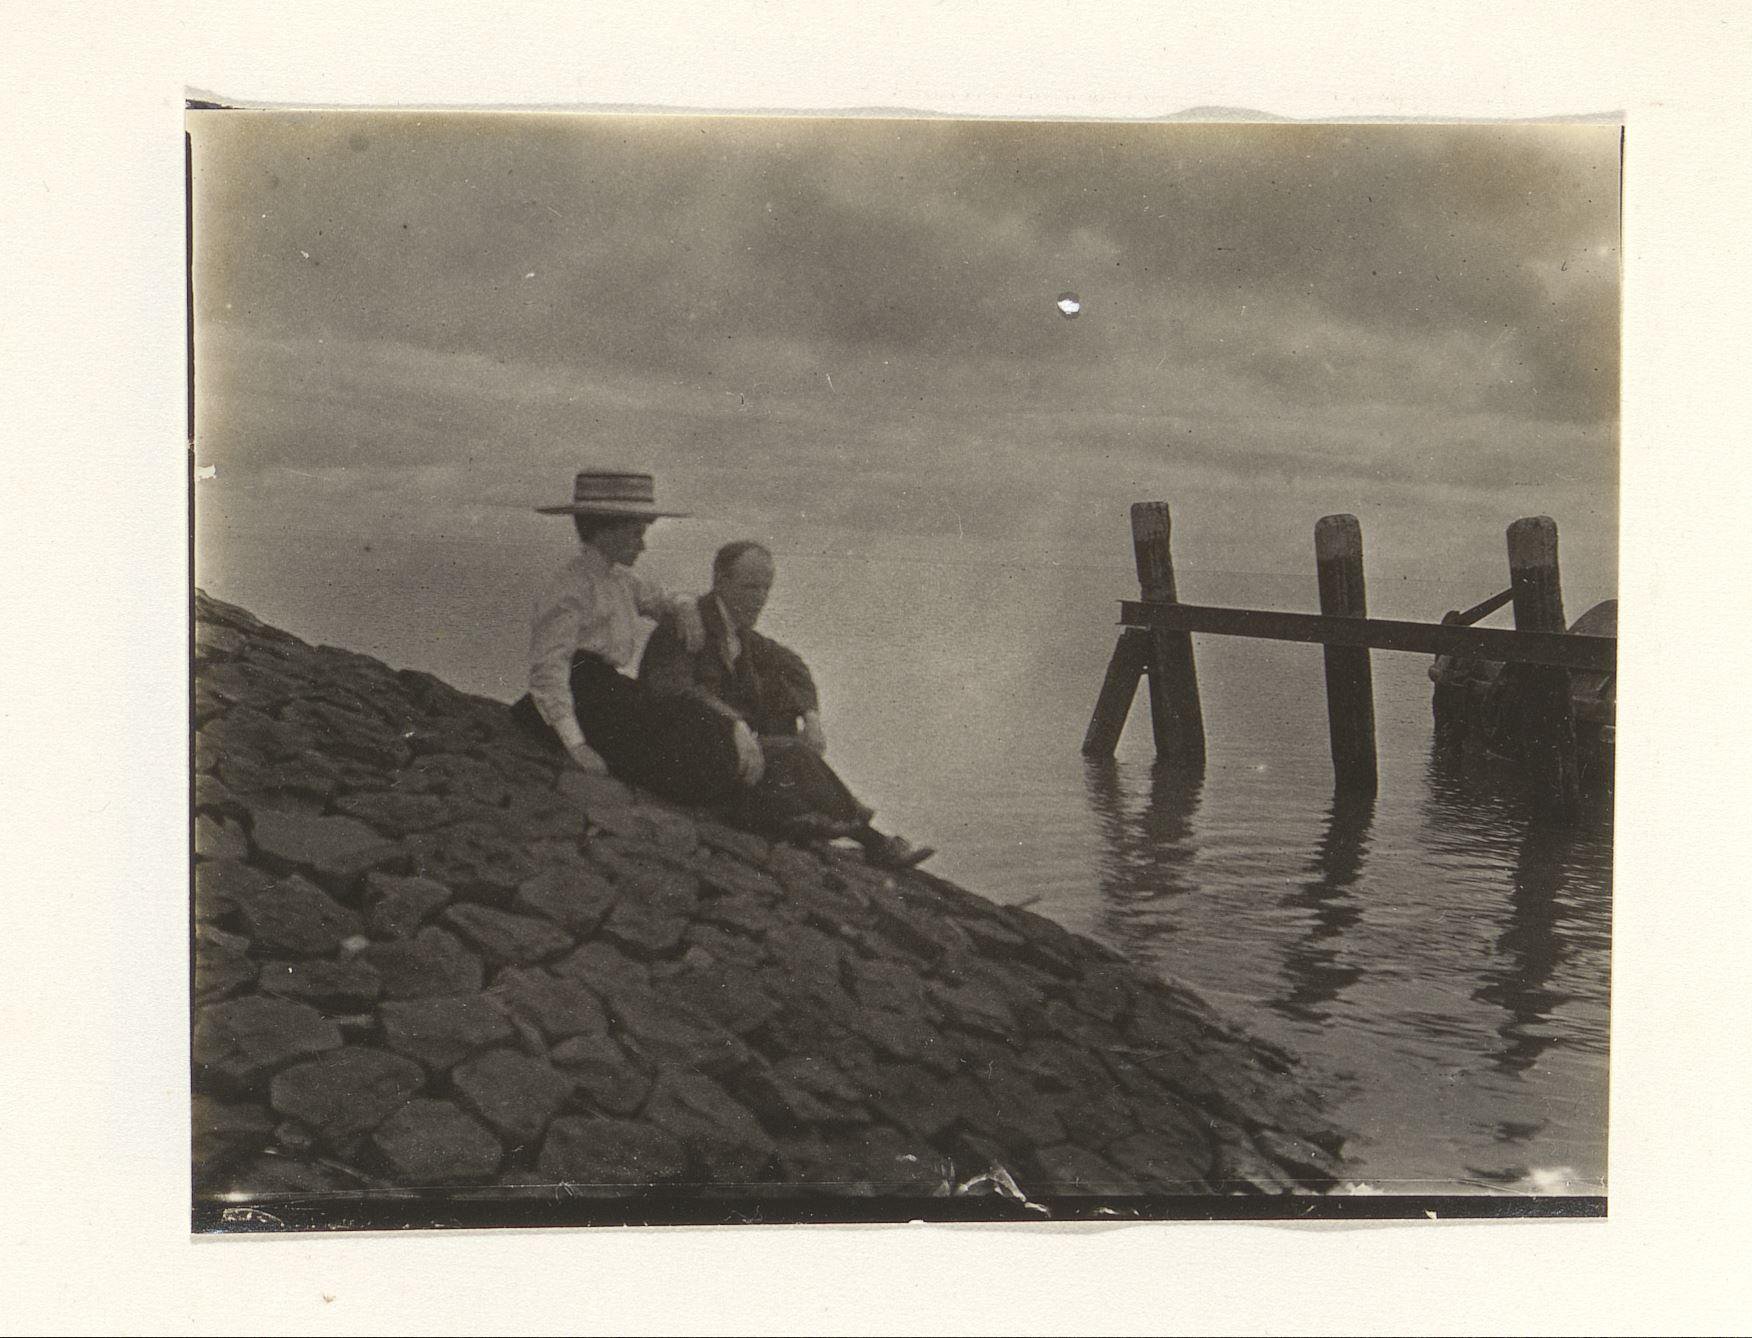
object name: album leaf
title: Vrouw aan een water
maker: george hidderley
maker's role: fotograaf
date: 1900-1910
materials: paper, photographic support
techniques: gelatin silver print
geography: volendam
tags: adult woman, historical persons, landscapes with waters, waterscapes, seascapes (in the temperate zone)